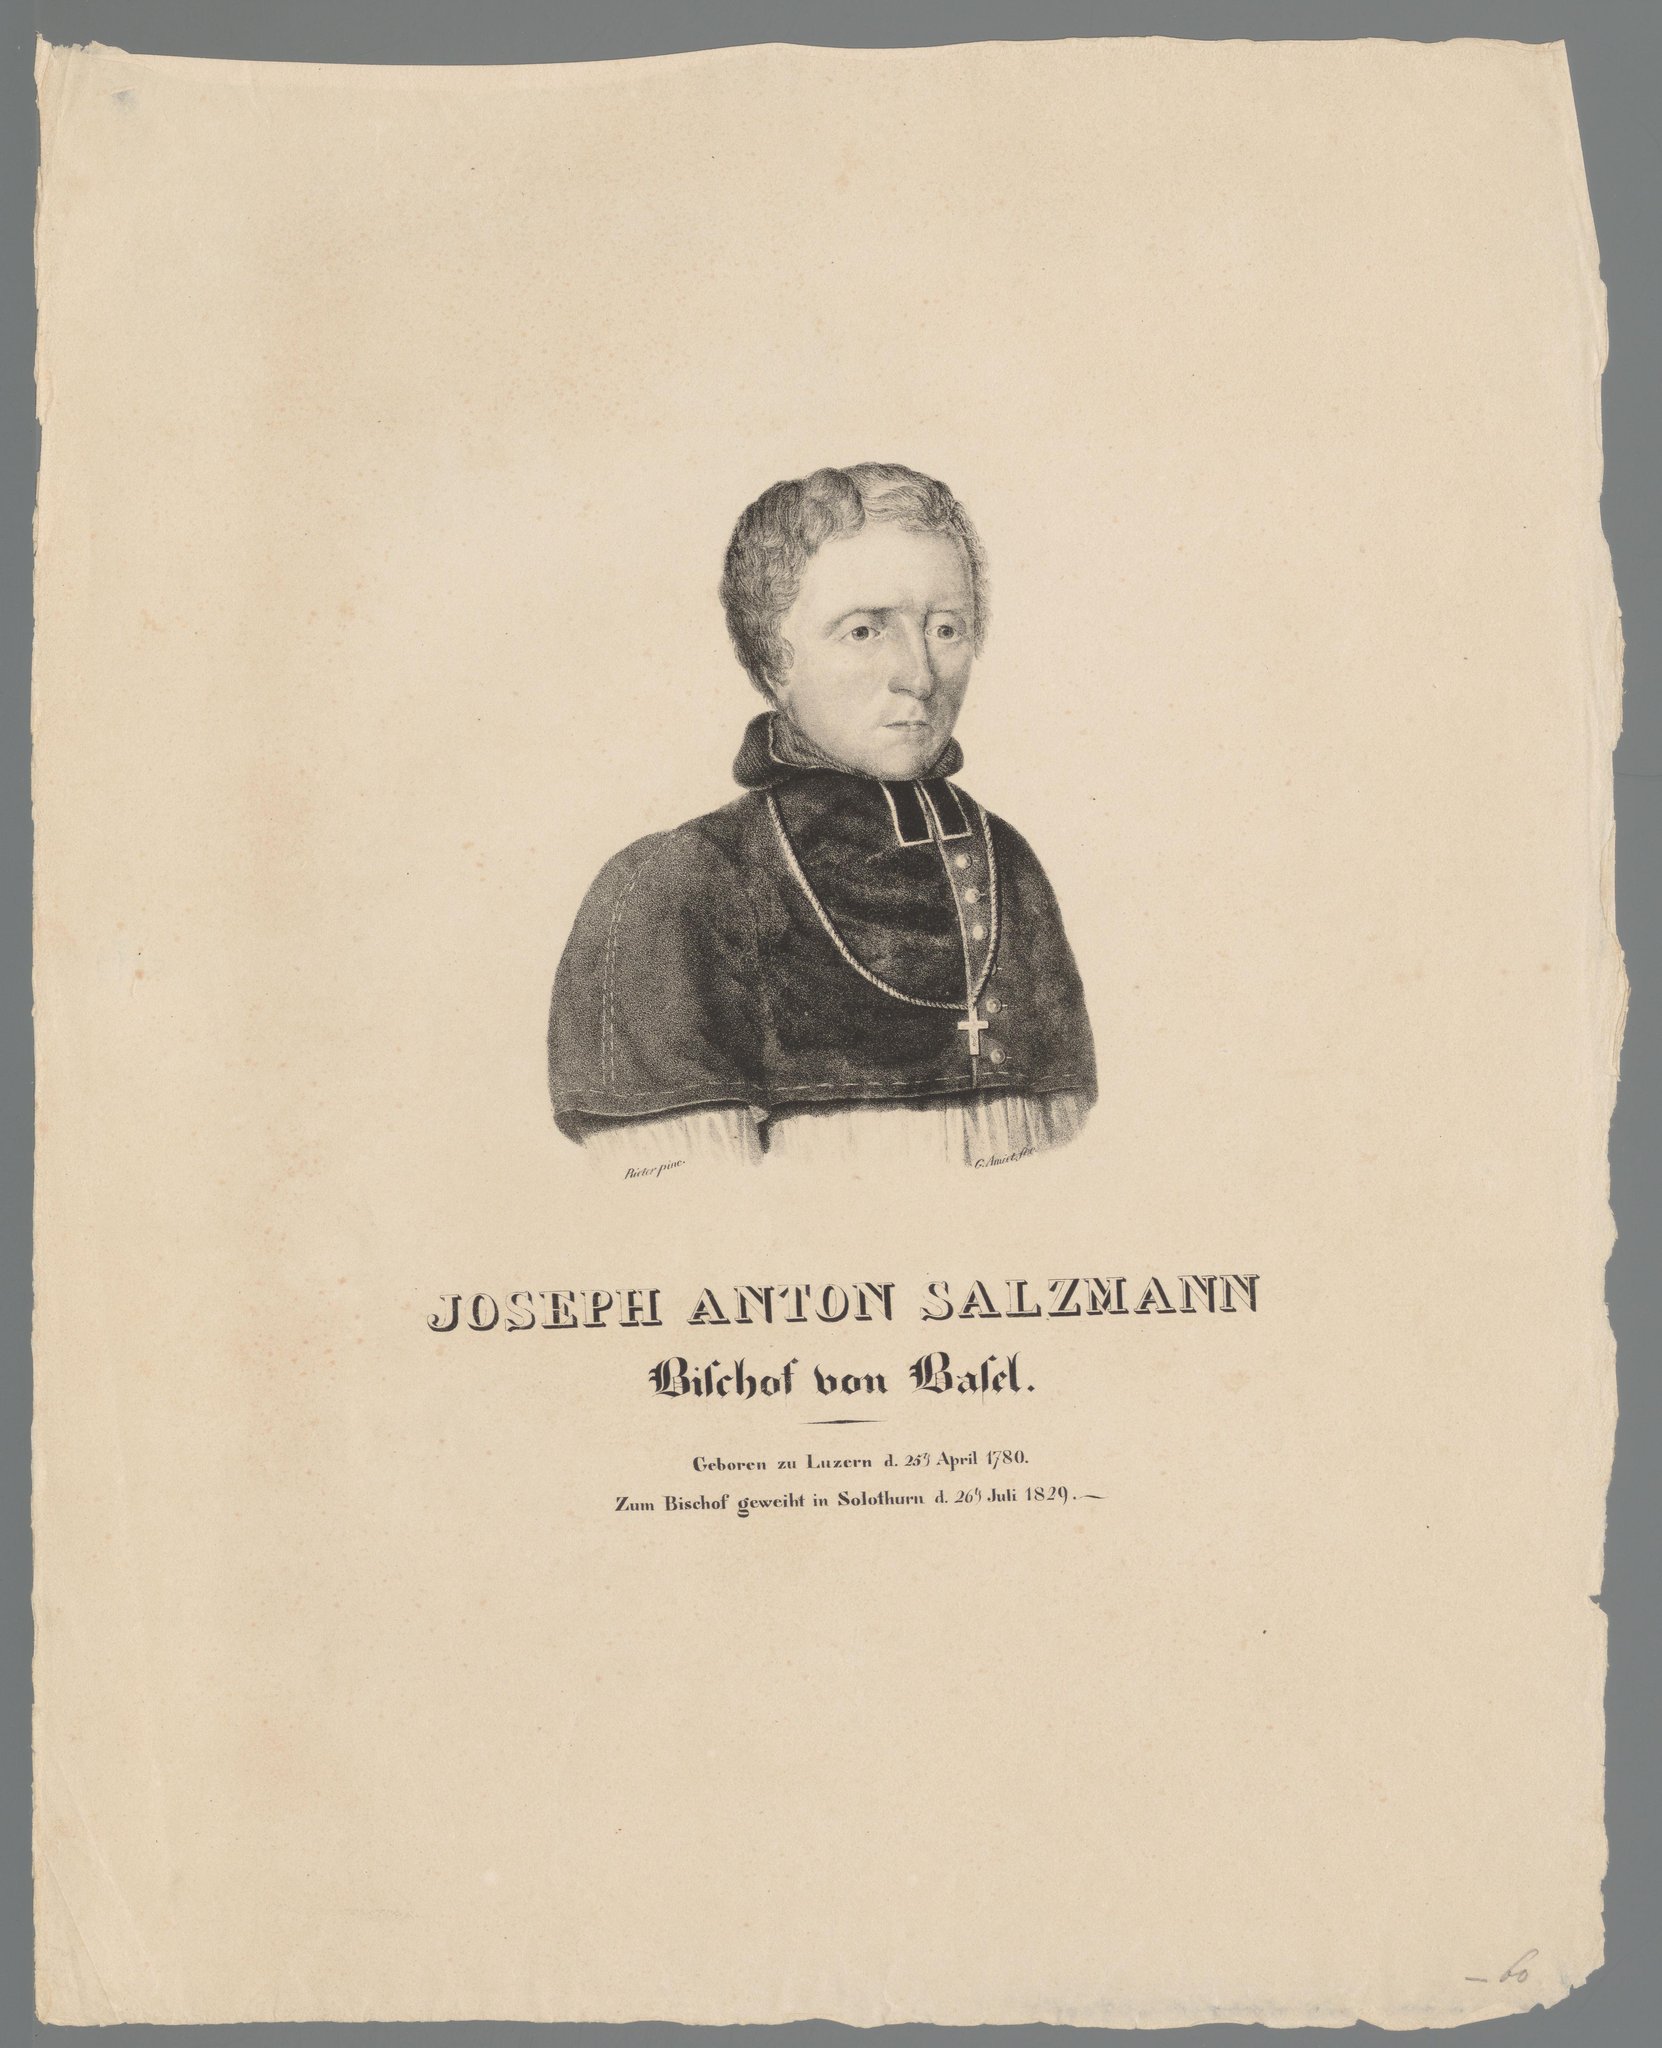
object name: print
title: Joseph Anton Salzmann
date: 1816-1856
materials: paper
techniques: lithograph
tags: archbishop, bishop, etc. (roman catholic), historical persons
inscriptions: collector's mark: Lugt 2228